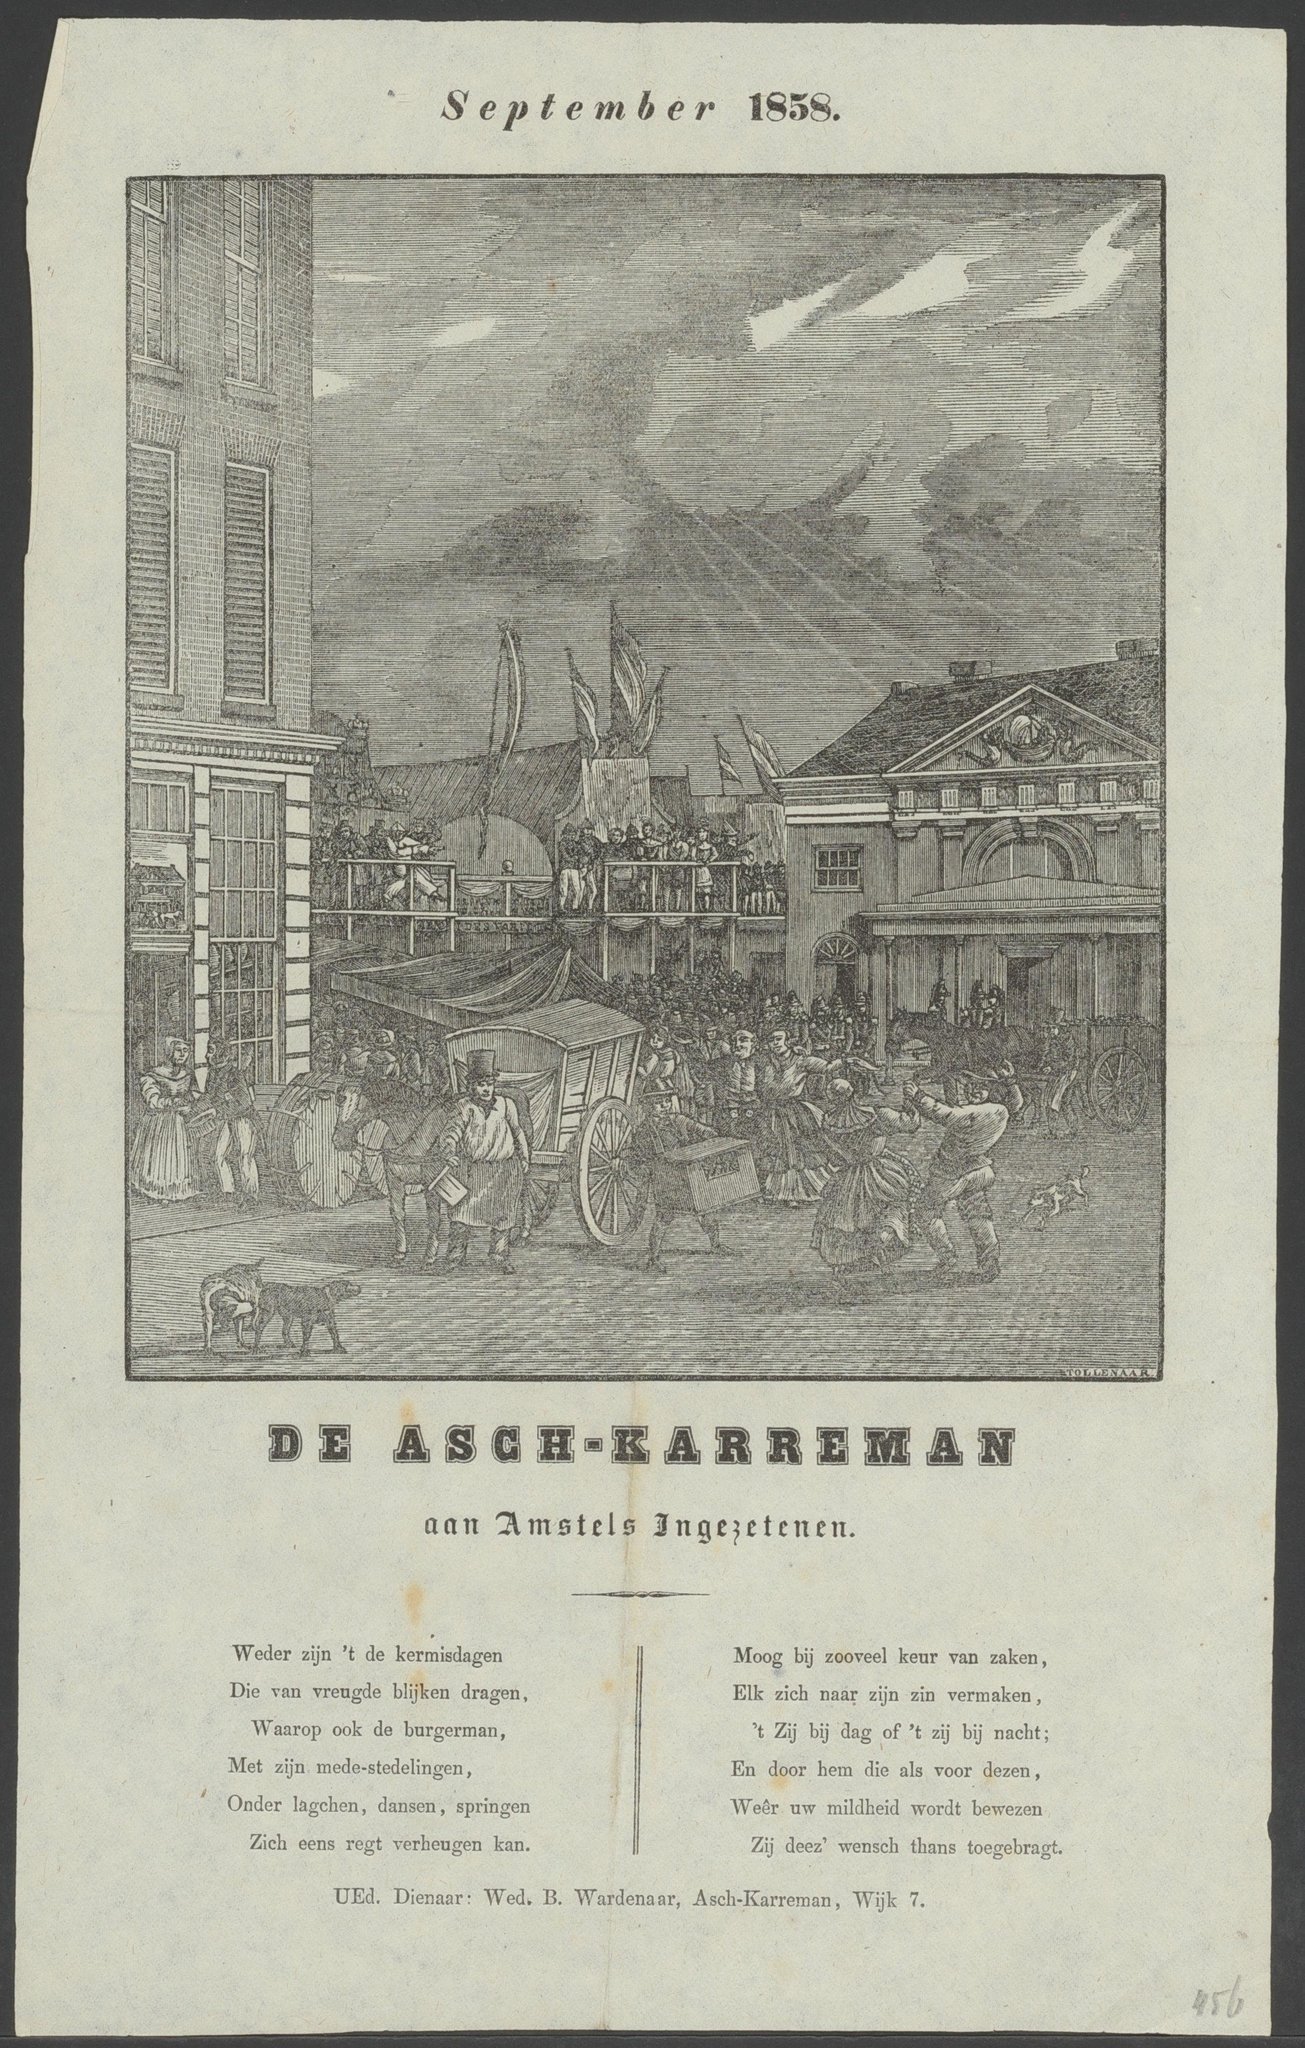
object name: fair print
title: Asch-Karmans kermis-wensch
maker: dirk wijbrand tollenaar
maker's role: print maker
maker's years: 1808-1858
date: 1858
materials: paper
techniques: letterpress printing, engraving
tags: pleasure fair and circus, garbage collection, amsterdam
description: Kermisprent namens de askarrenmannen (karrenman of vuilnisman) te Amsterdam, september 1858. Gezicht op de kermis op de Botermarkt met de Regulierswaag. Op de markt twee vuilniskarren. Onderaan een gedicht in twee kolommen. Namens Weduwe van B. Wardenaar, de askarreman van wijk no. 7. Onderwerpsrubrieken binnen de Atlas Zeden en Gewoonten: Zeden en gewoonten in engeren zin, Volksleven, Volksbladen, Nieuwjaars- en Kerstwenschen, Amsterdam.